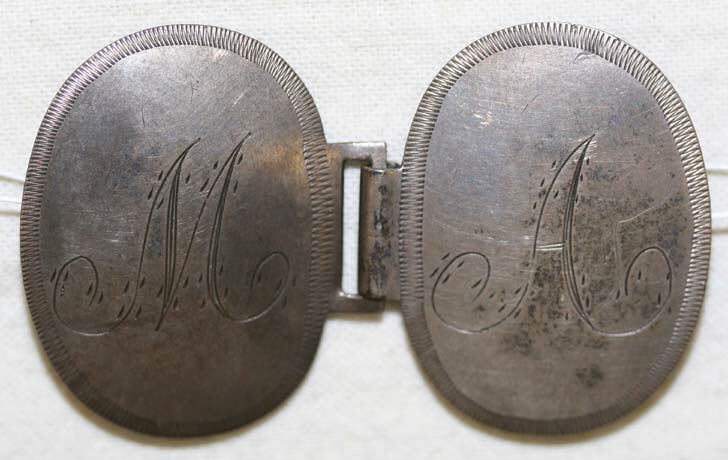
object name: belt buckle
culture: american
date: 1801-1900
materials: silver